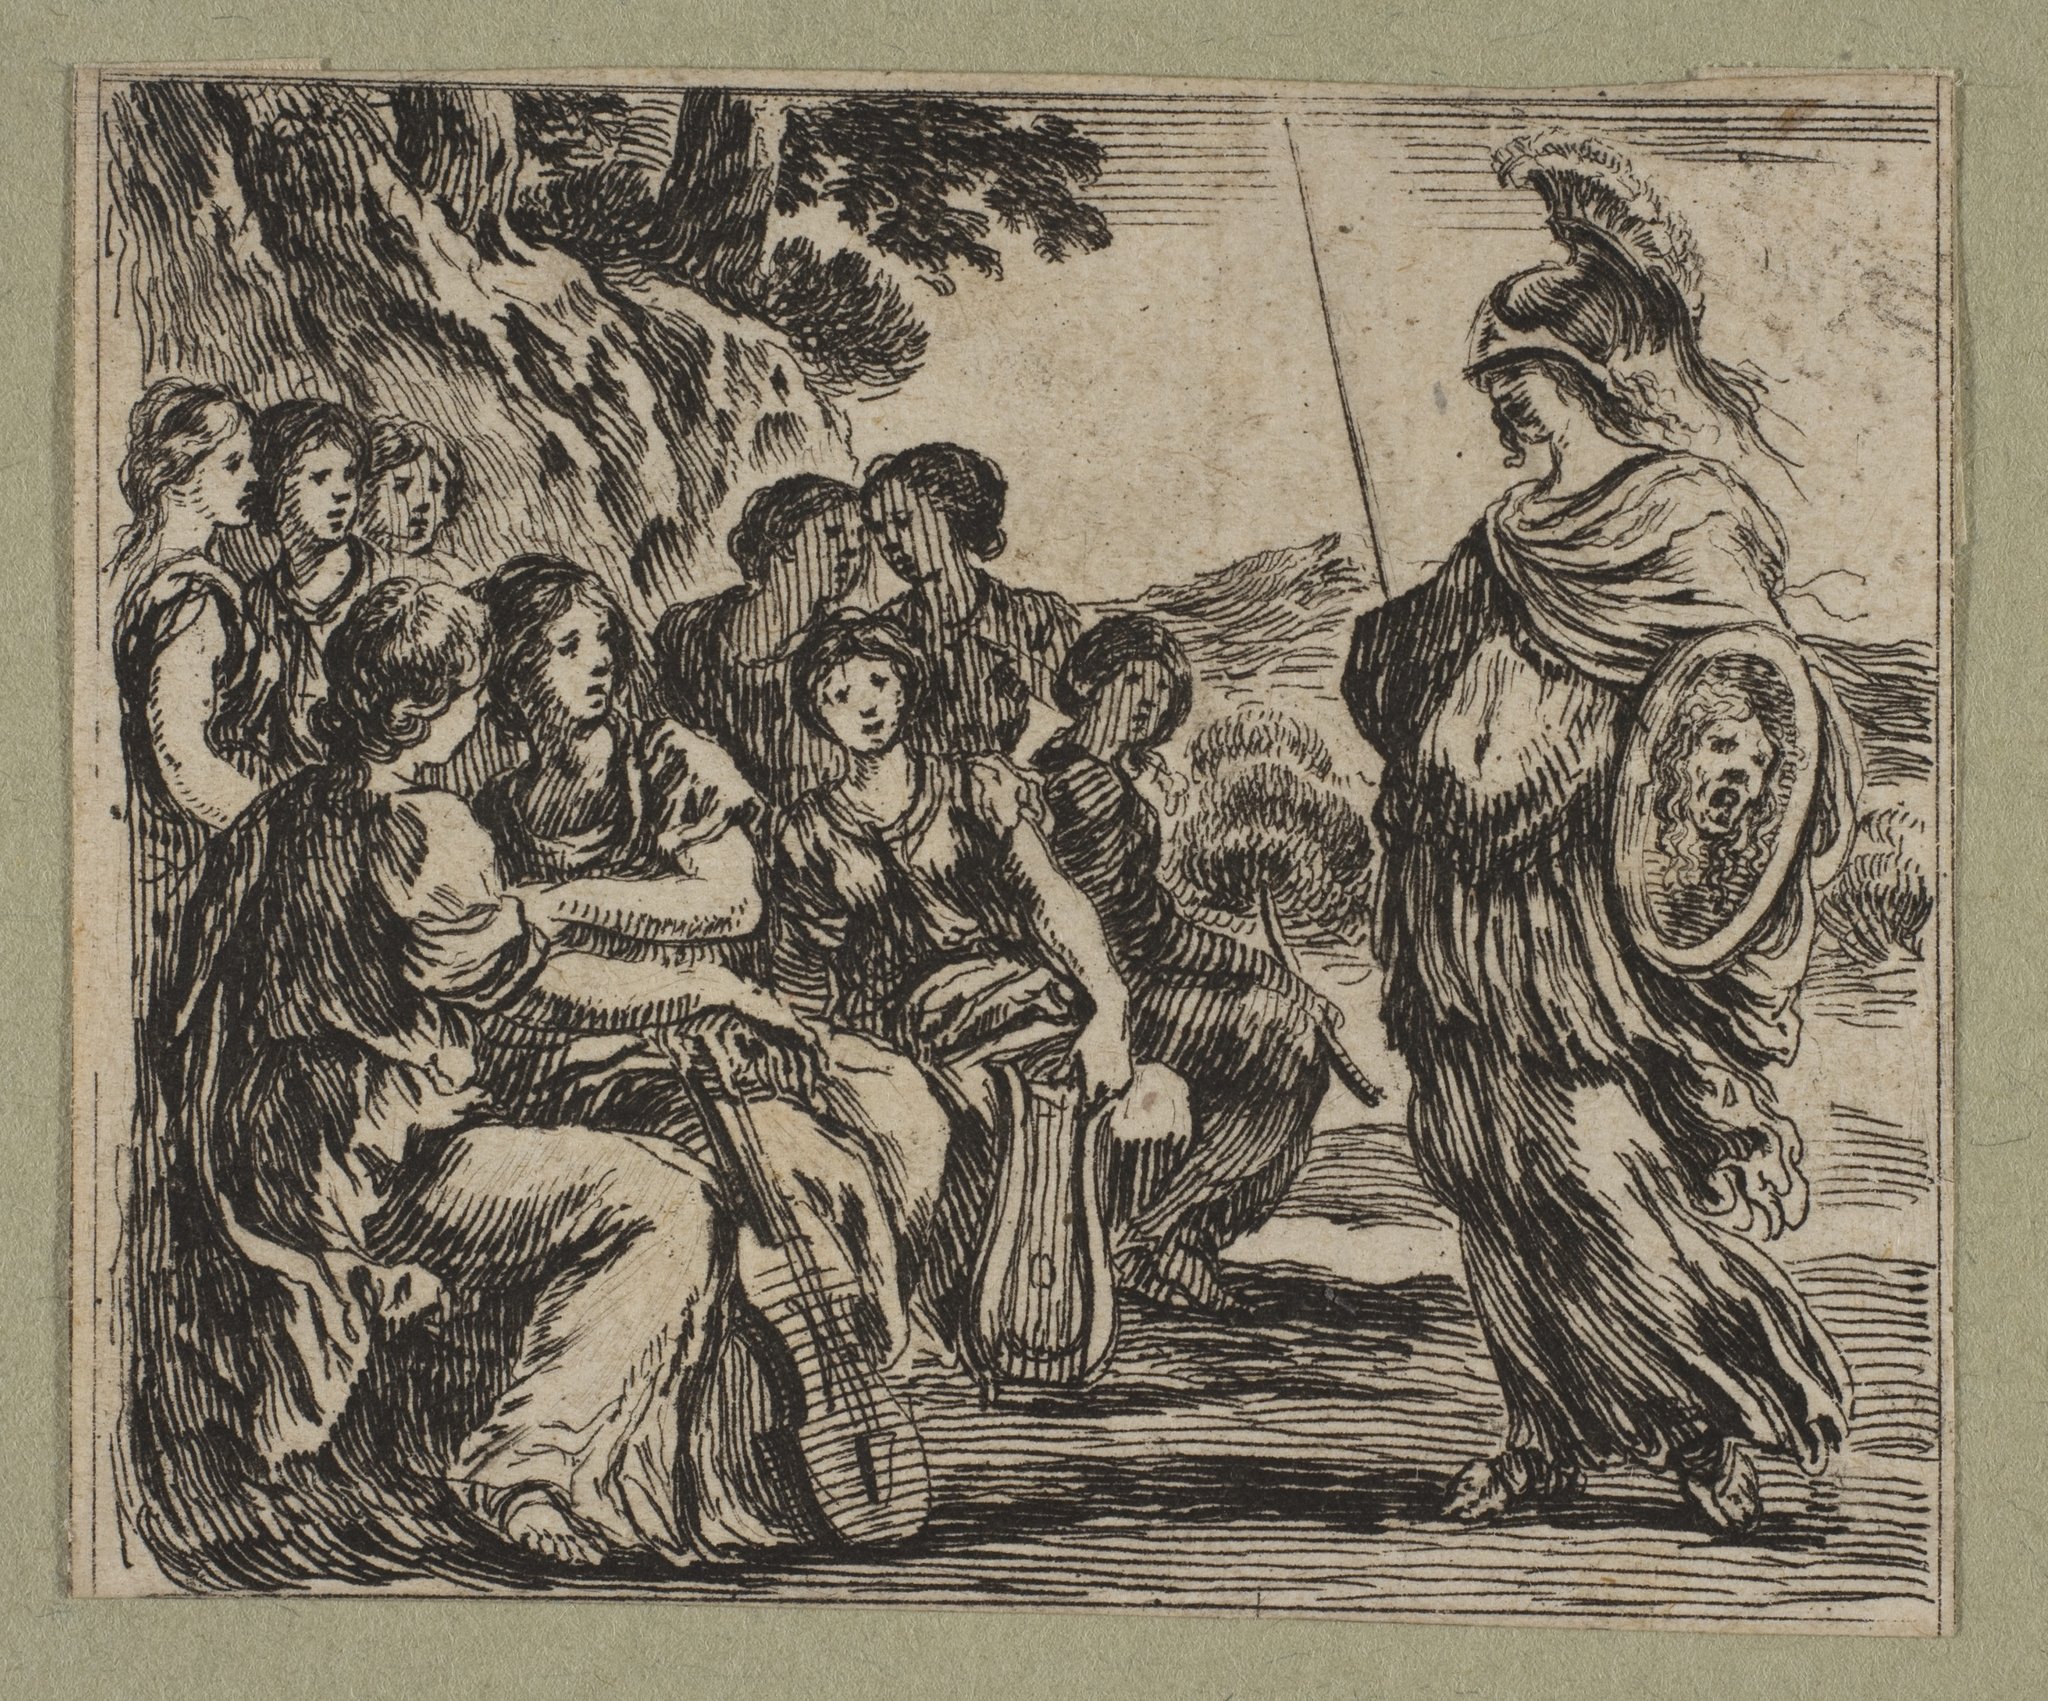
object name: print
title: Les neuf Muses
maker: stefano della bella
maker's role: artist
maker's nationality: italian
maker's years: 1610-1664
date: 1644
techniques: etching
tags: men,muses